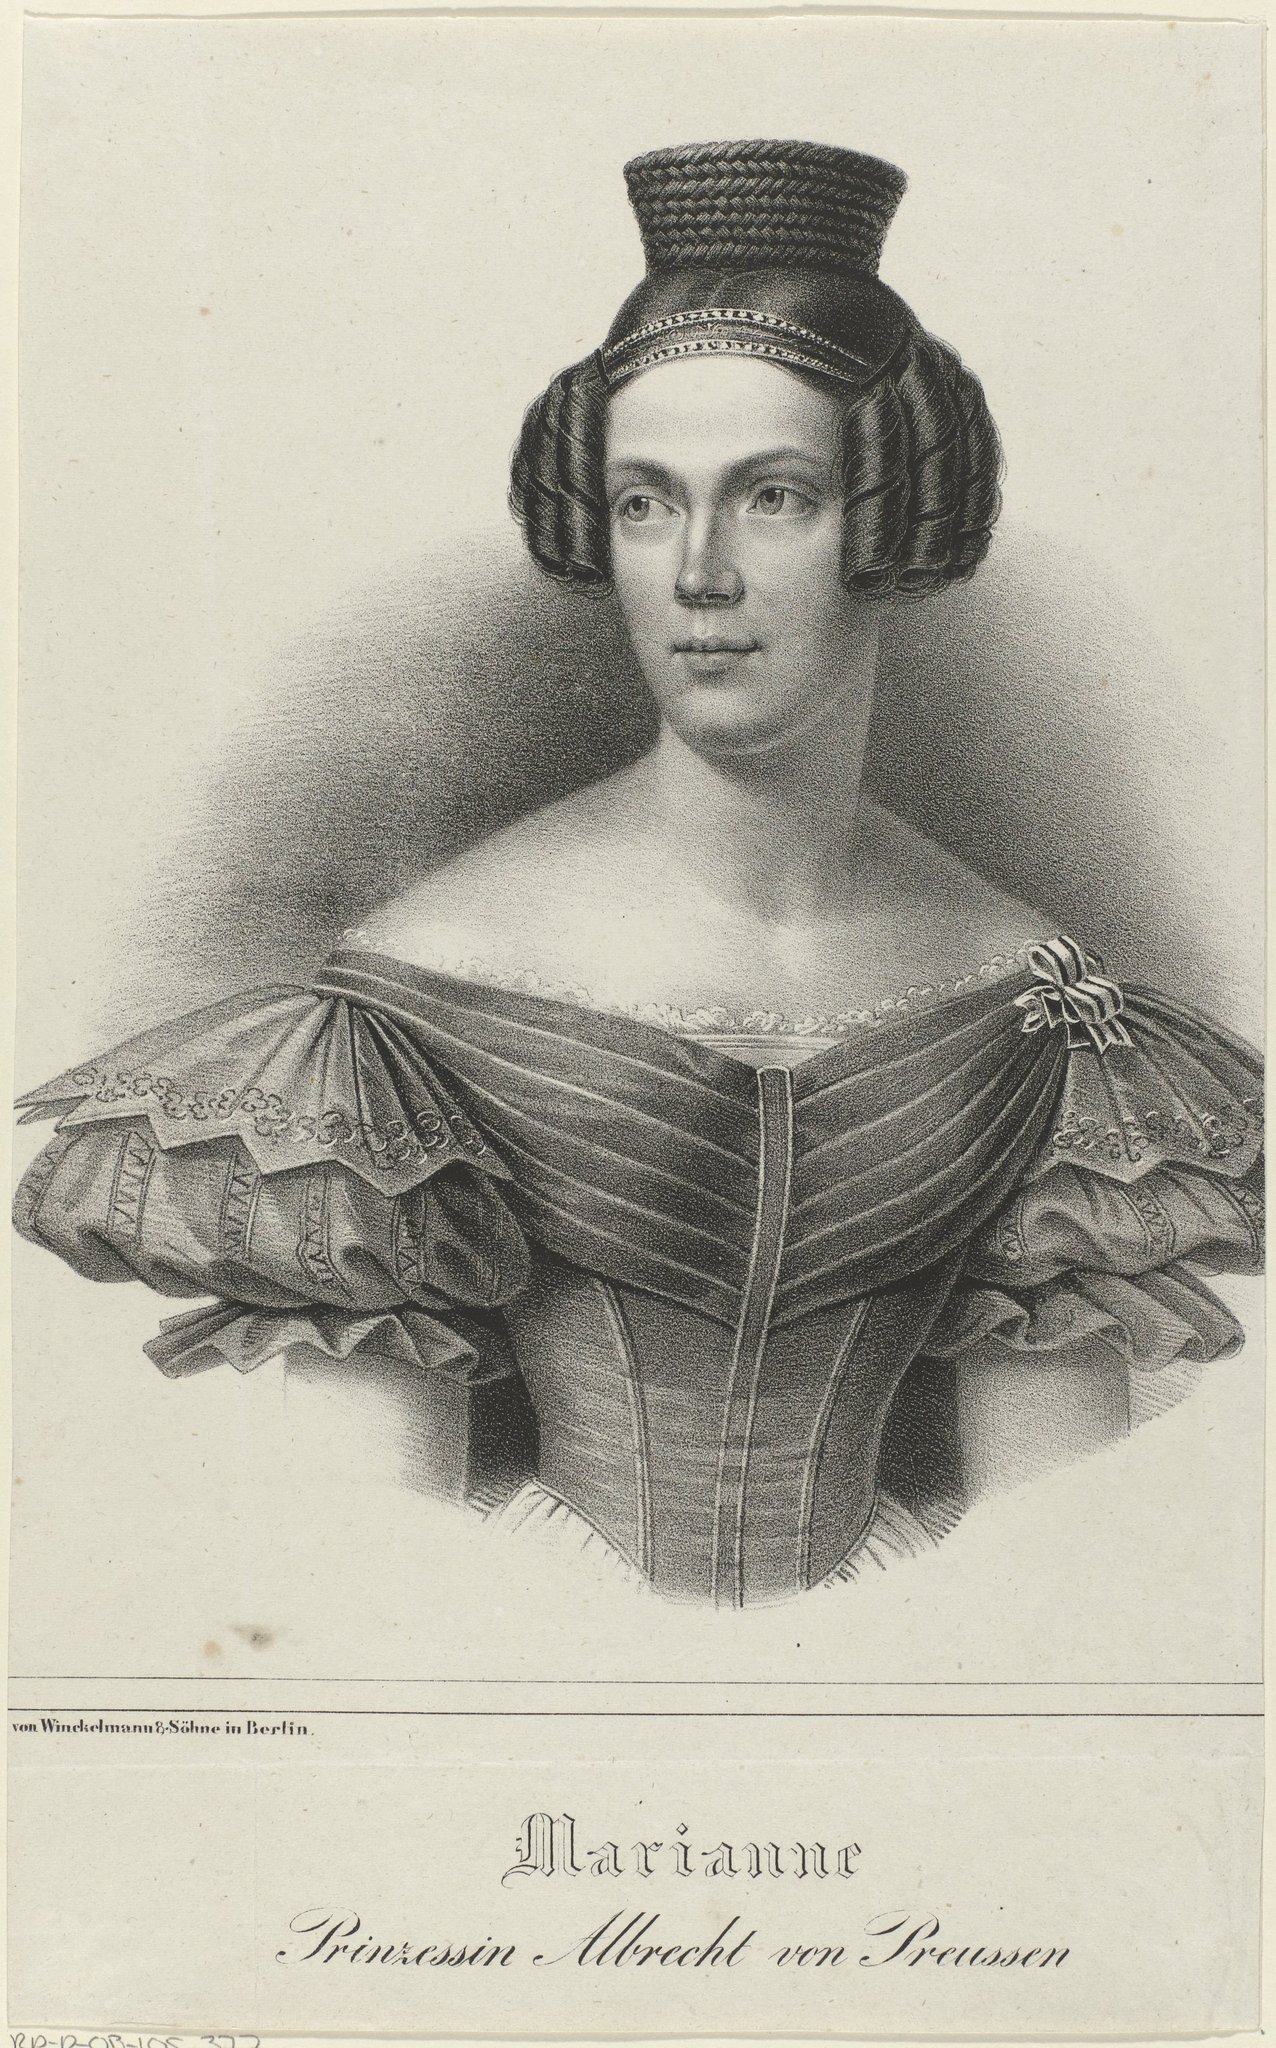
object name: print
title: Portret van Marianne, prinses der Nederlanden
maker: Anonymous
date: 1830-1899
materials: paper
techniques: lithograph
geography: berlin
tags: marianne (prinses der nederlanden)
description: De hier vermelde titel verwijst naar de hoogst verkregen titel van de geportretteerde, niet per se naar de titel die de geportretteerde op deze voorstelling draagt.